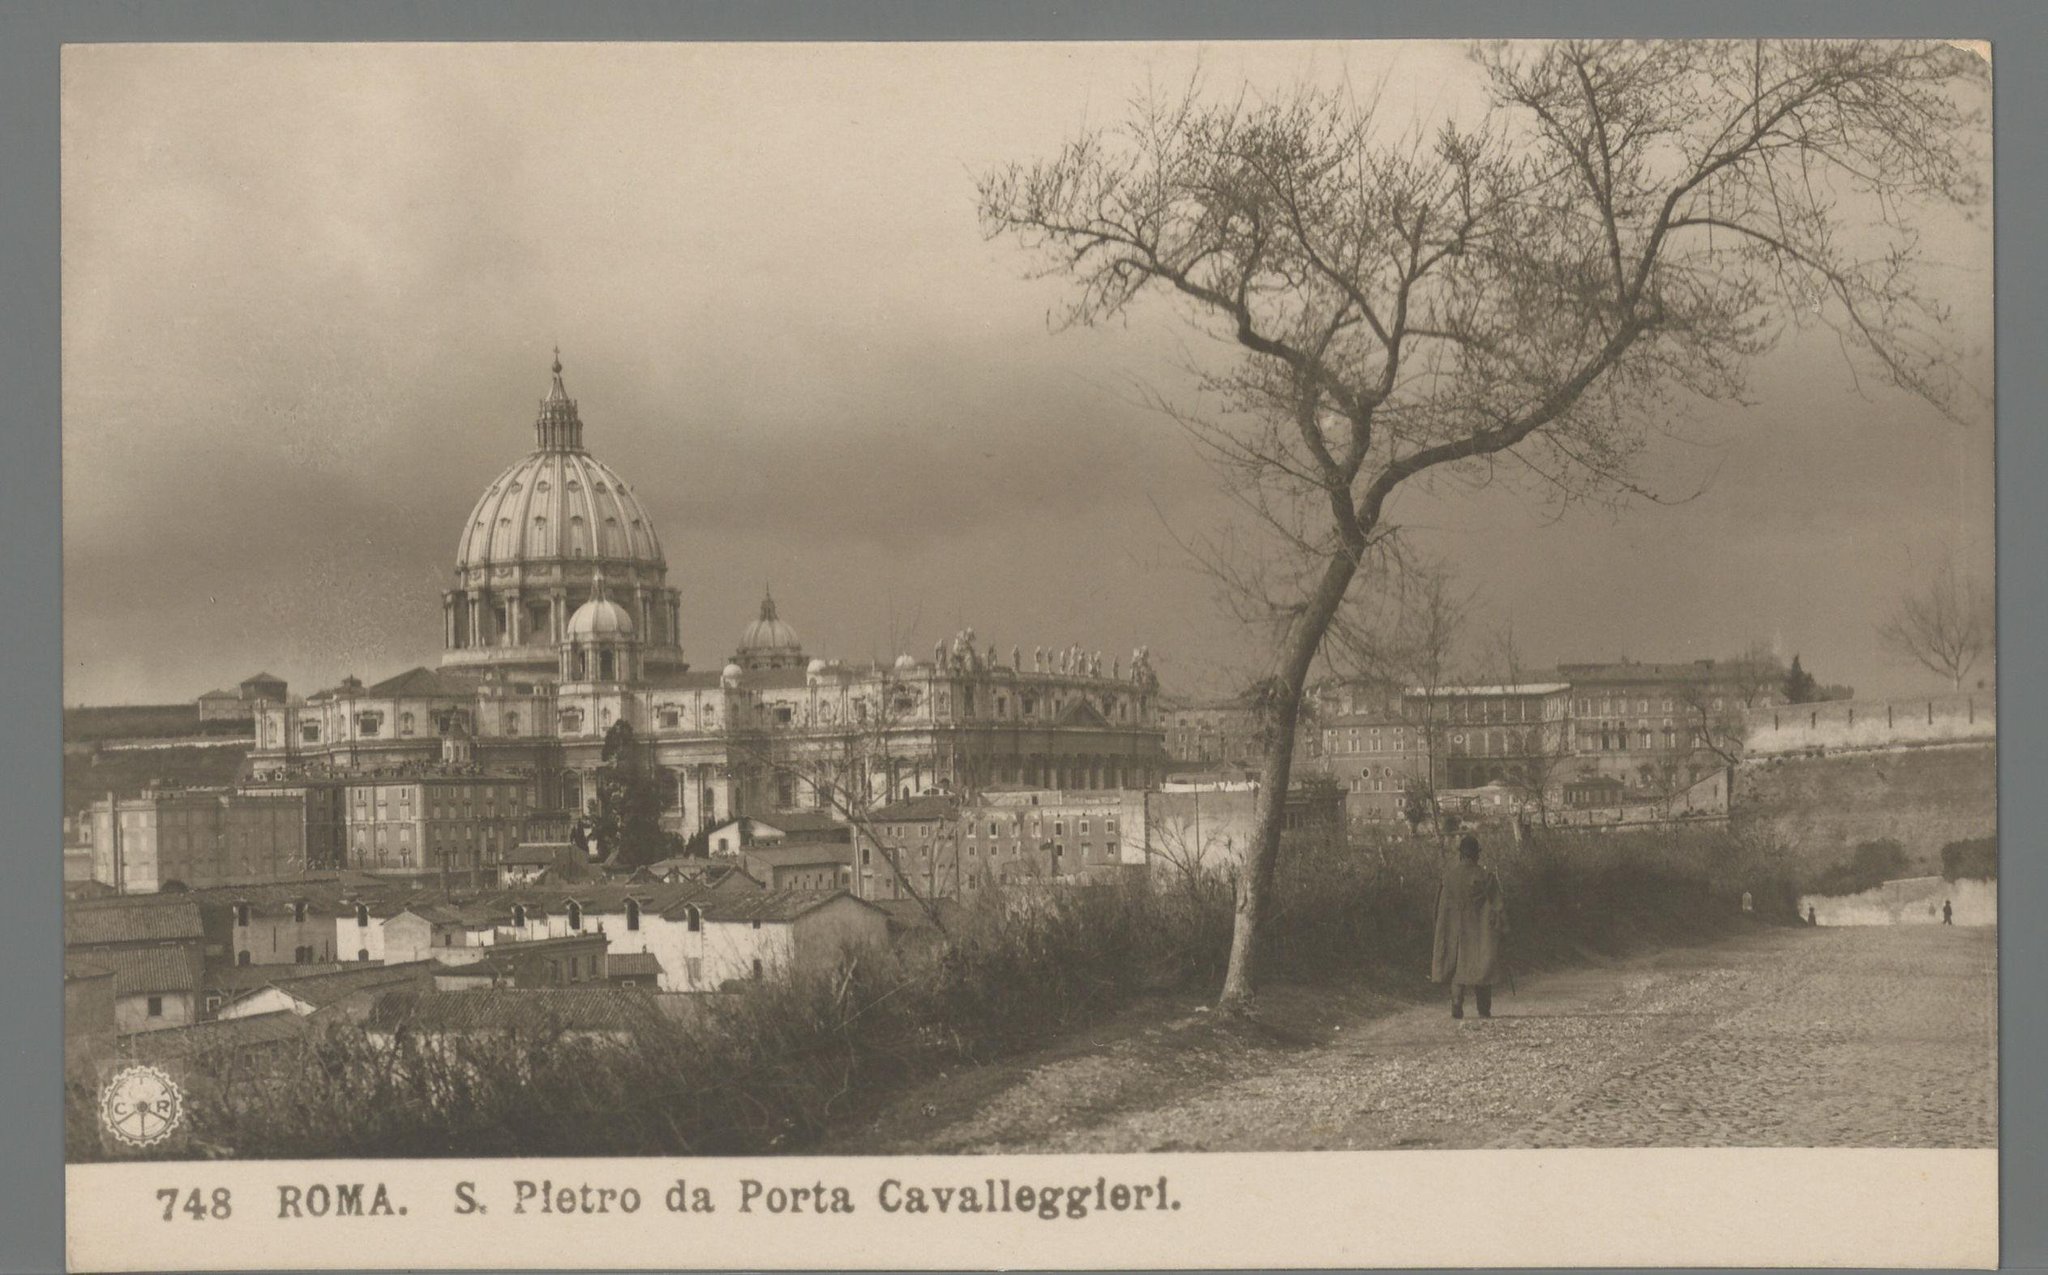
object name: photograph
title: Roma. S. Pietro da Porta Cavalleggieri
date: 1906-1920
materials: photographic support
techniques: photography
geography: rome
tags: church (exterior), dome ~ architecture, city-view, and landscape with man-made constructions (+ city(-scape) with figures, staffage)